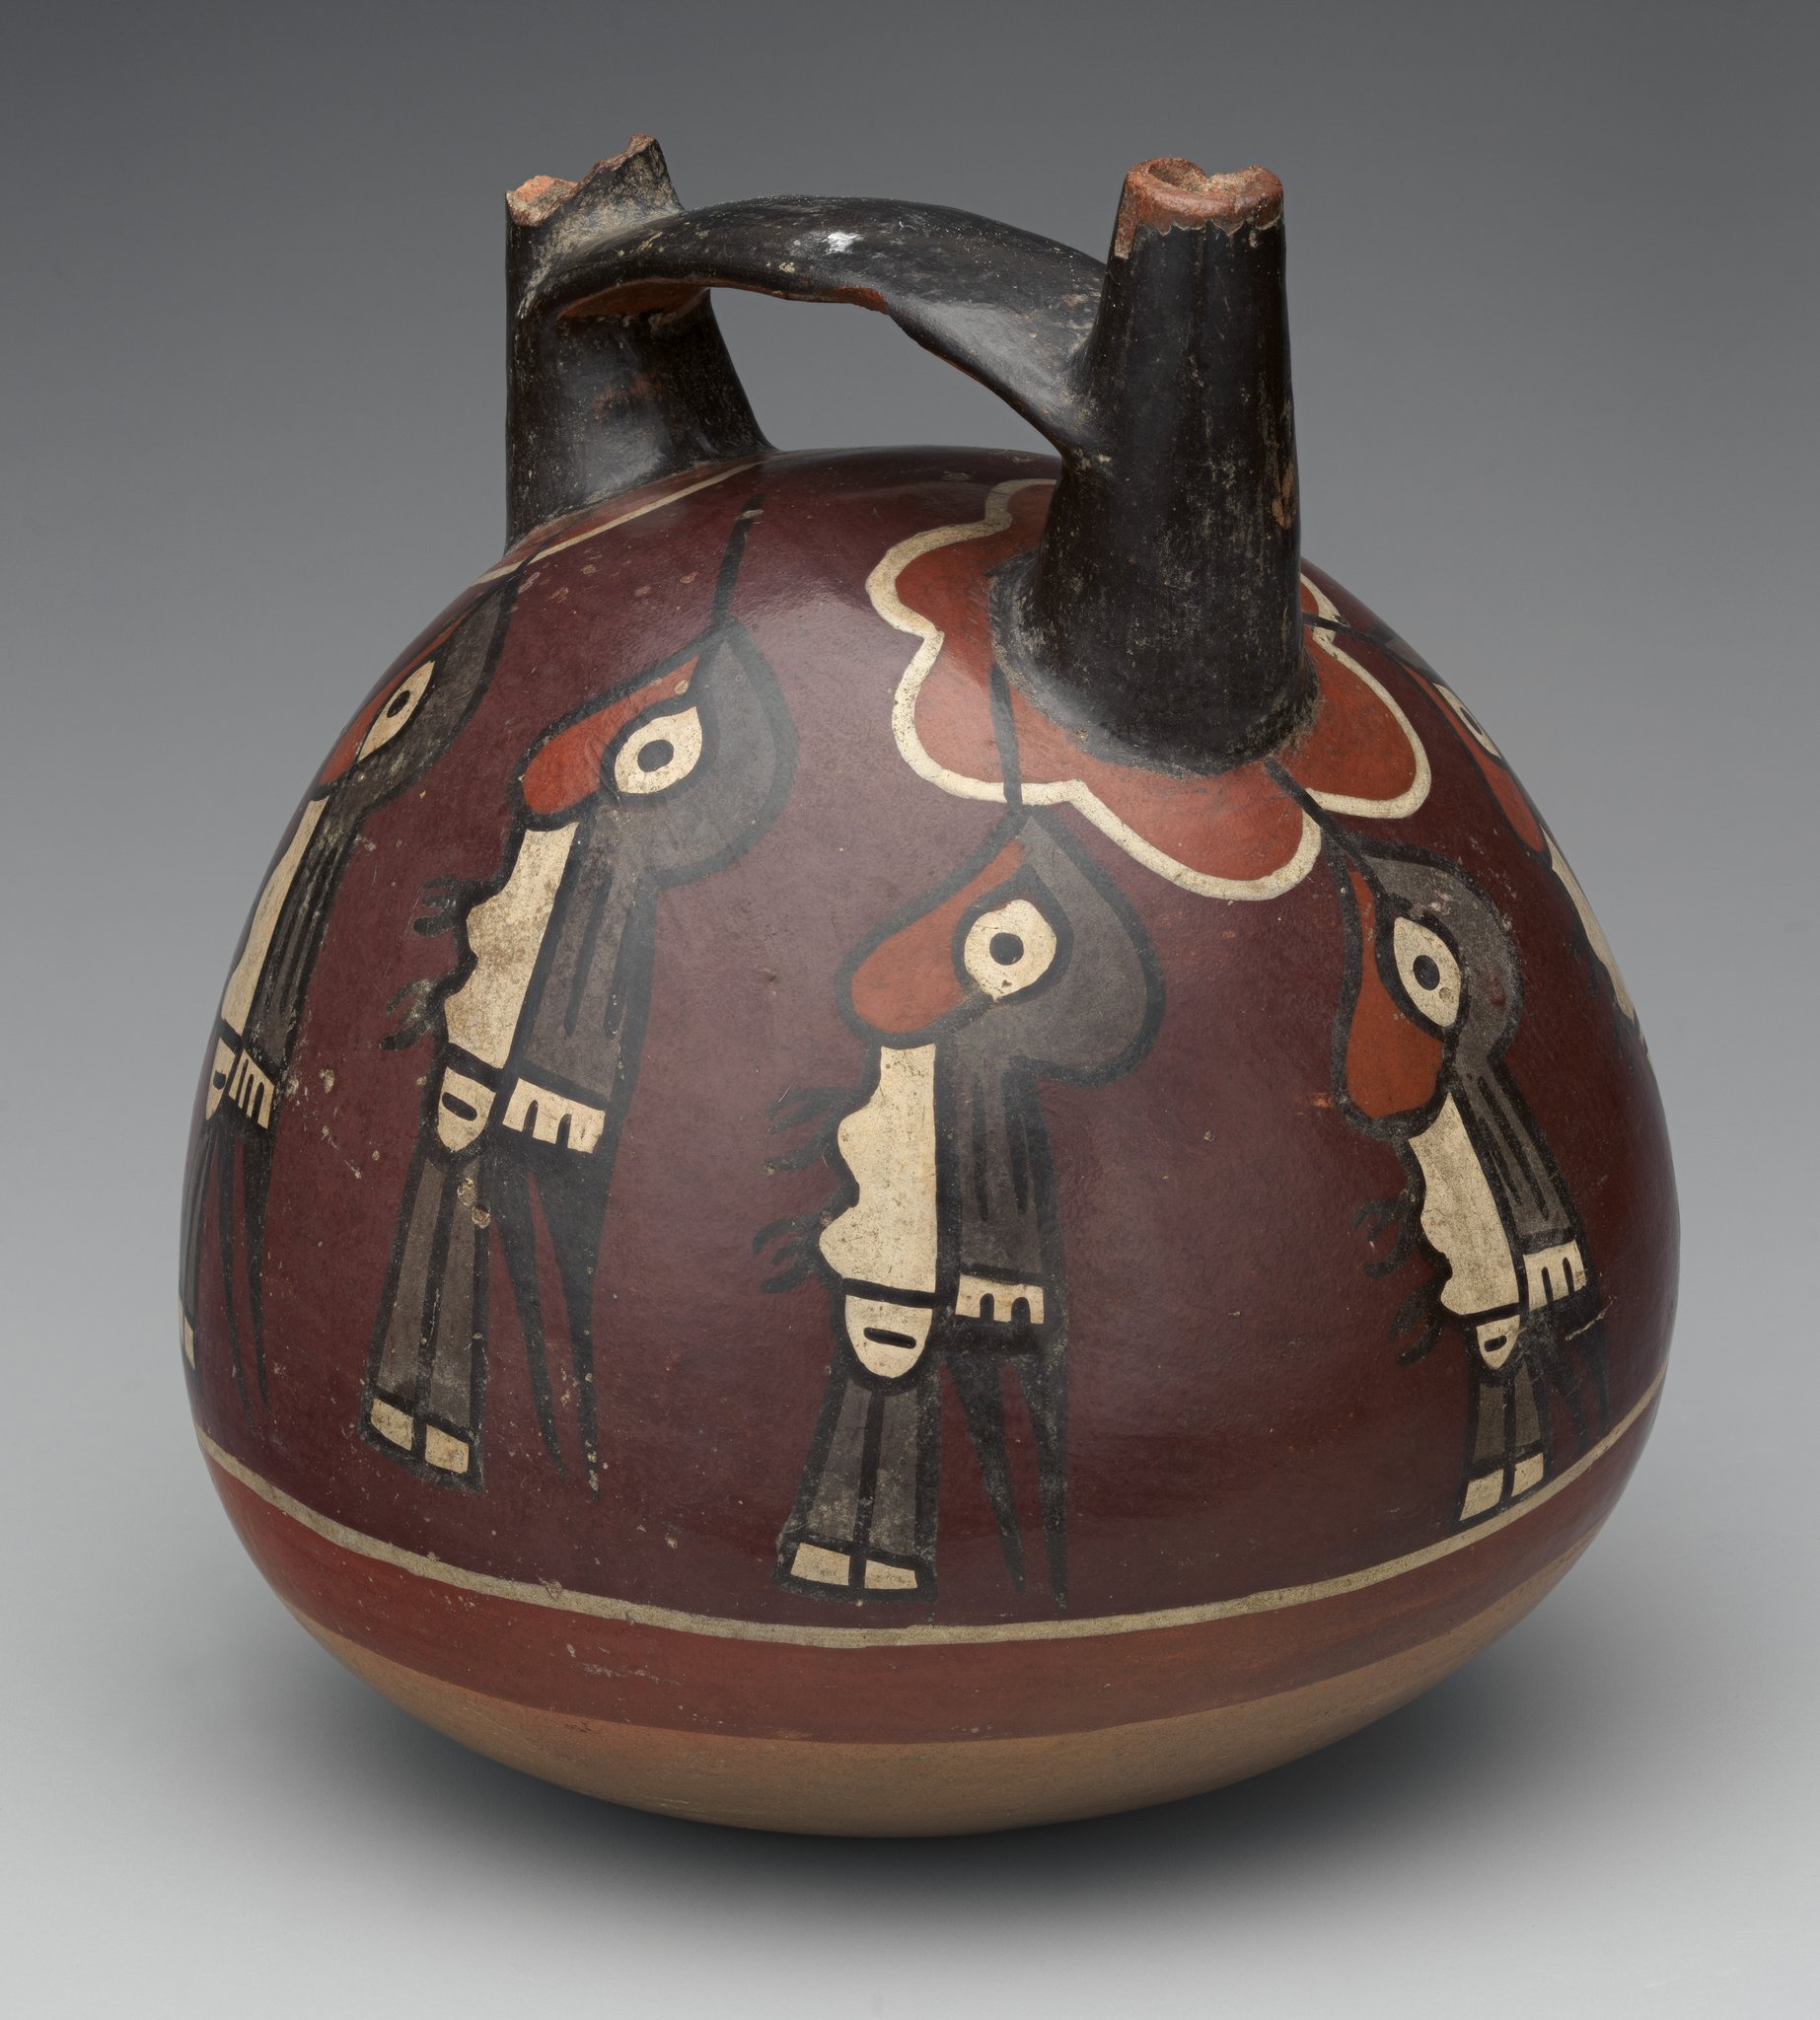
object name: bottle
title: Bottle with hummingbirds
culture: nasca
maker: nasca artist(s)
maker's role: artist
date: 1-400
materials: ceramic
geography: peru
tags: birds